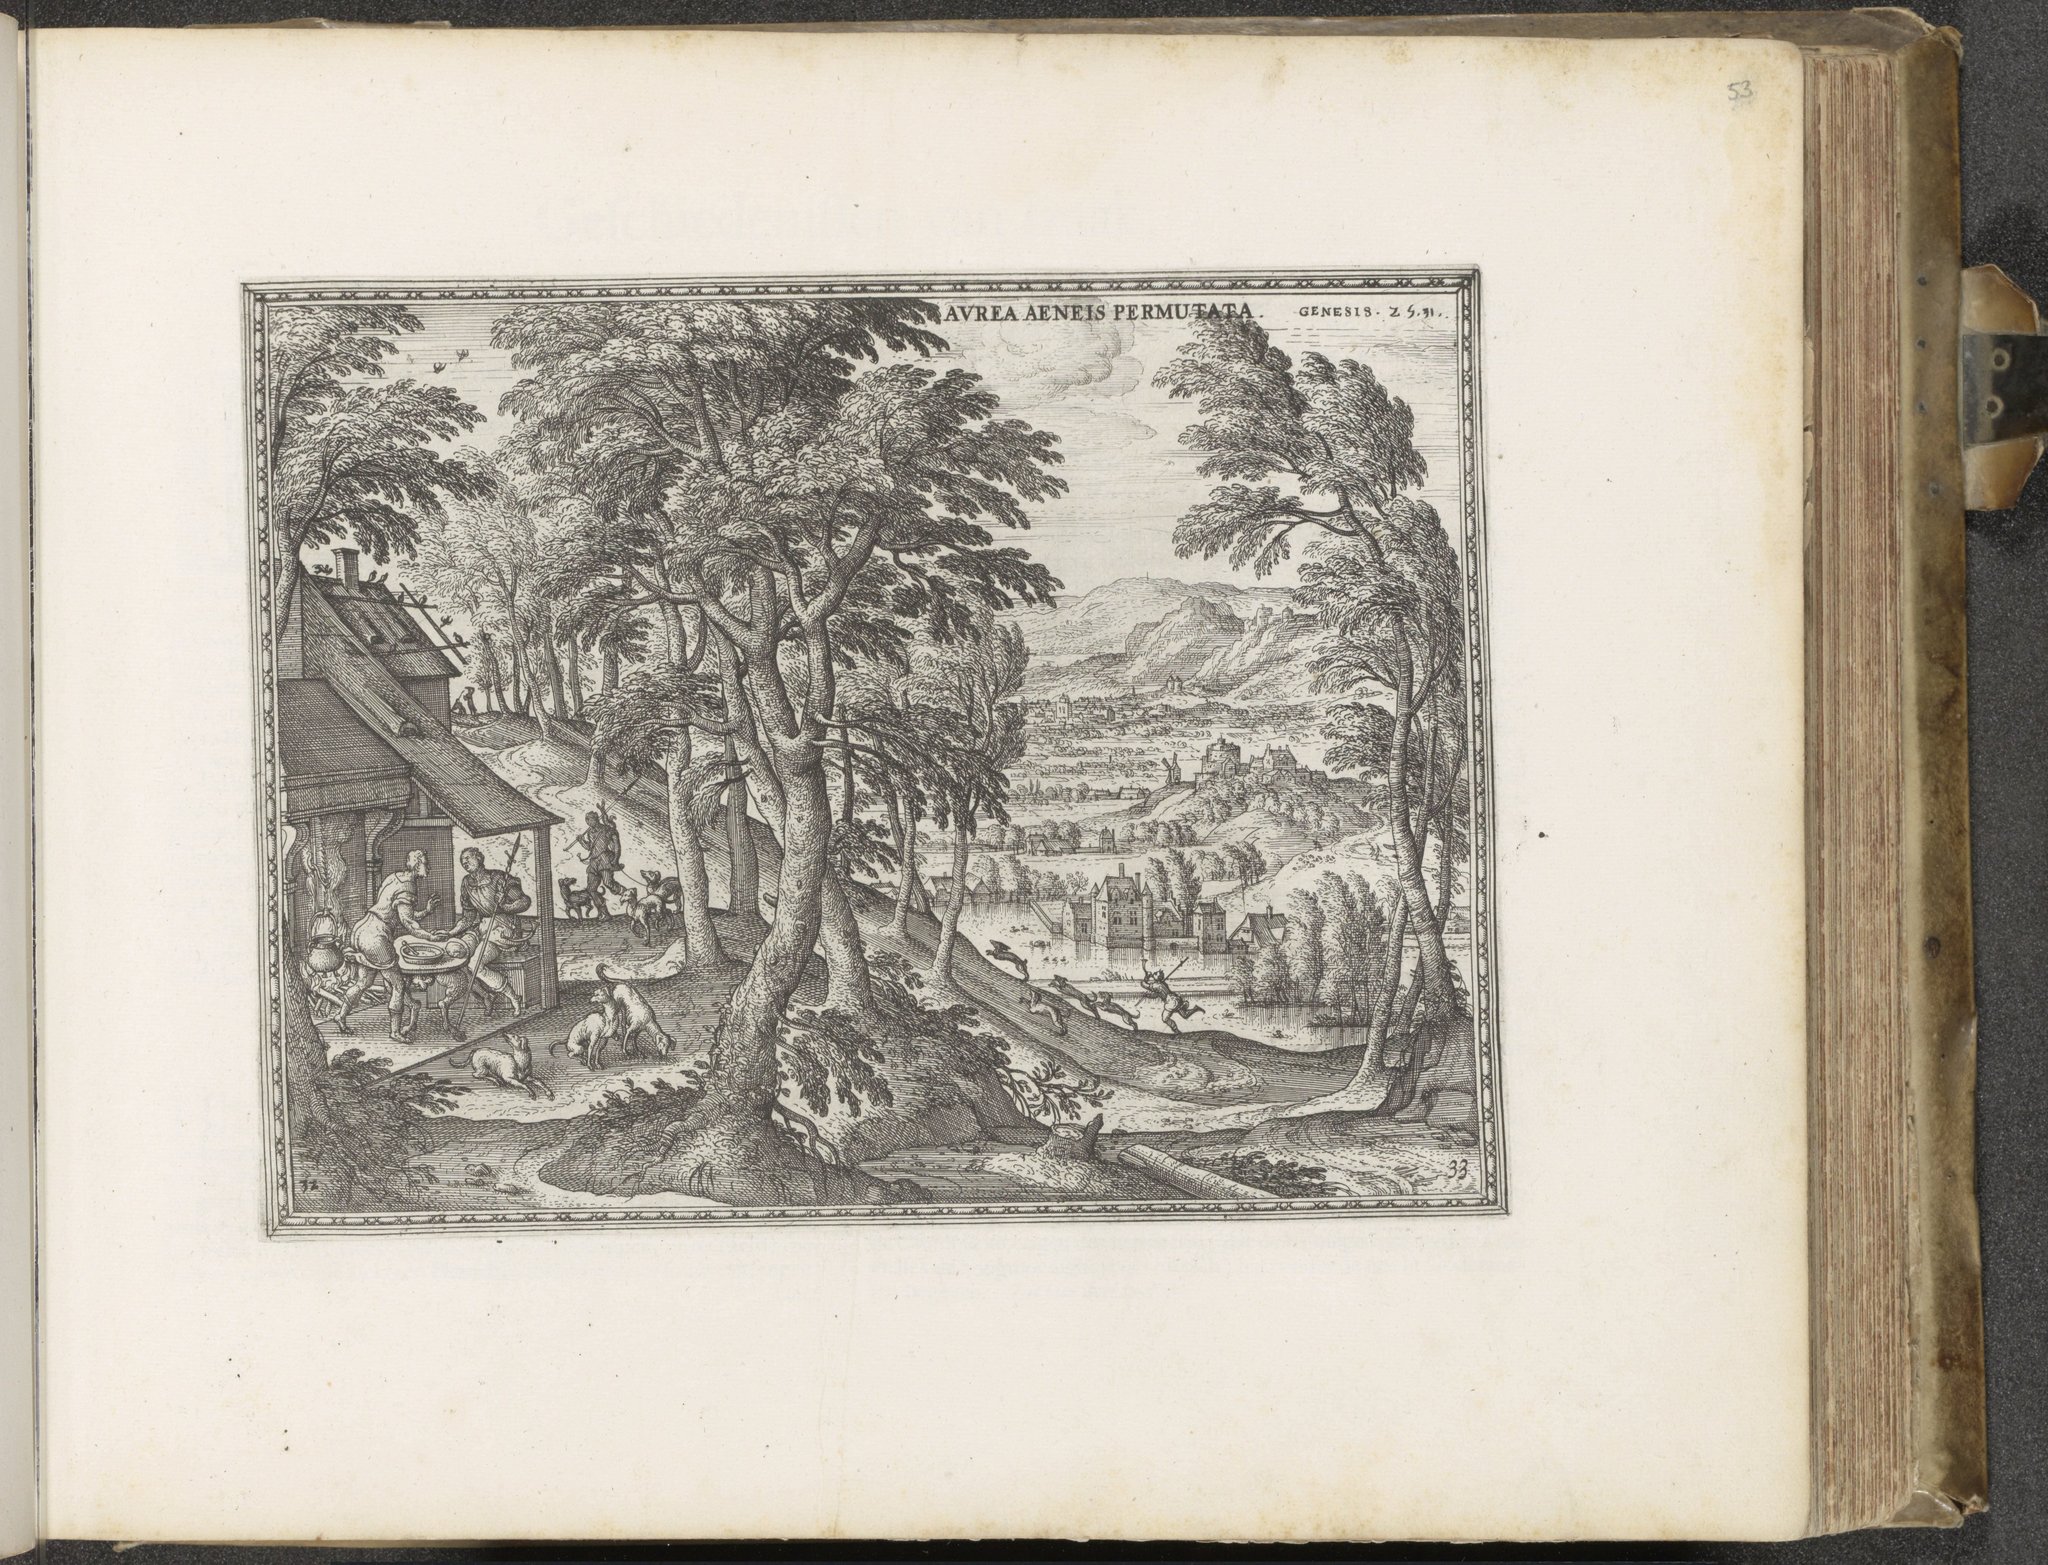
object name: album leaf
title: Avrea aeneis permutata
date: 1582-1593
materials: paper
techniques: etching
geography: amsterdam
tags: hunting dogs, hunter, forest, wood, blowing the hunting horn, old testament, esau, returning hungry from the hunt, sells his first birthright to jacob for a pottage of lentils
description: In een huis tegen een heuvel zit Esau, gekleed als jager, aan tafel. Tegenover hem staat Jakob. Hij koopt met het bord linzensoep voor hem het eerstegeboorterecht van Esau (Gen. 25:31). In het landschap jagers en jachthonden. De prent maakt deel uit van een album.